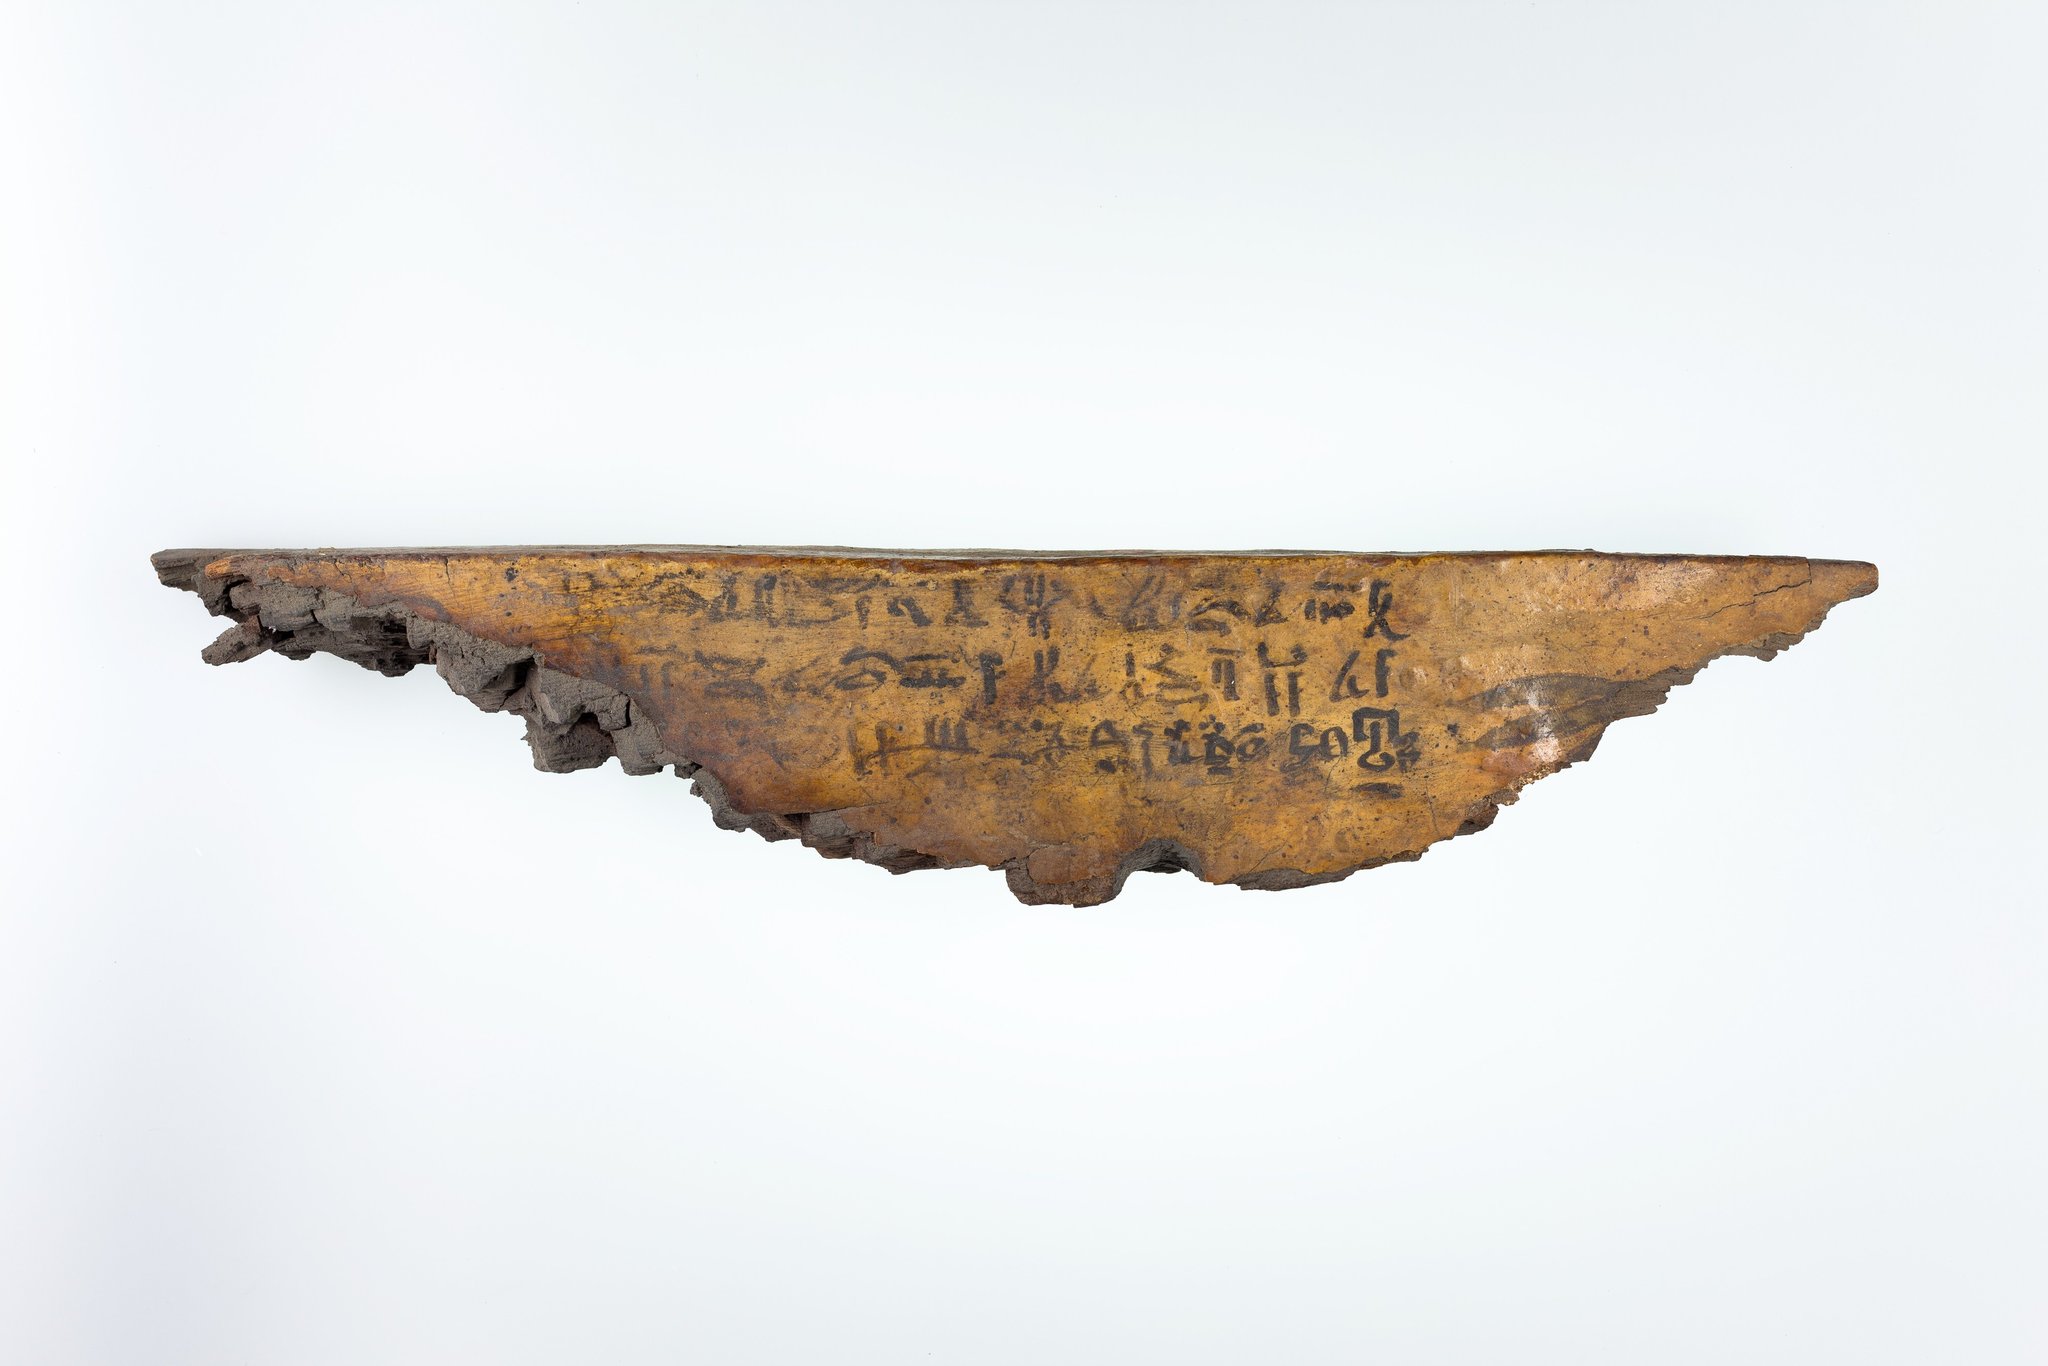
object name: writing board, sokar formula, nebit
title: Writing board fragment with Sokar formula for the benefit of Nebit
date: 2030-1981 BCE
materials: ink, plaster, wood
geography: egypt